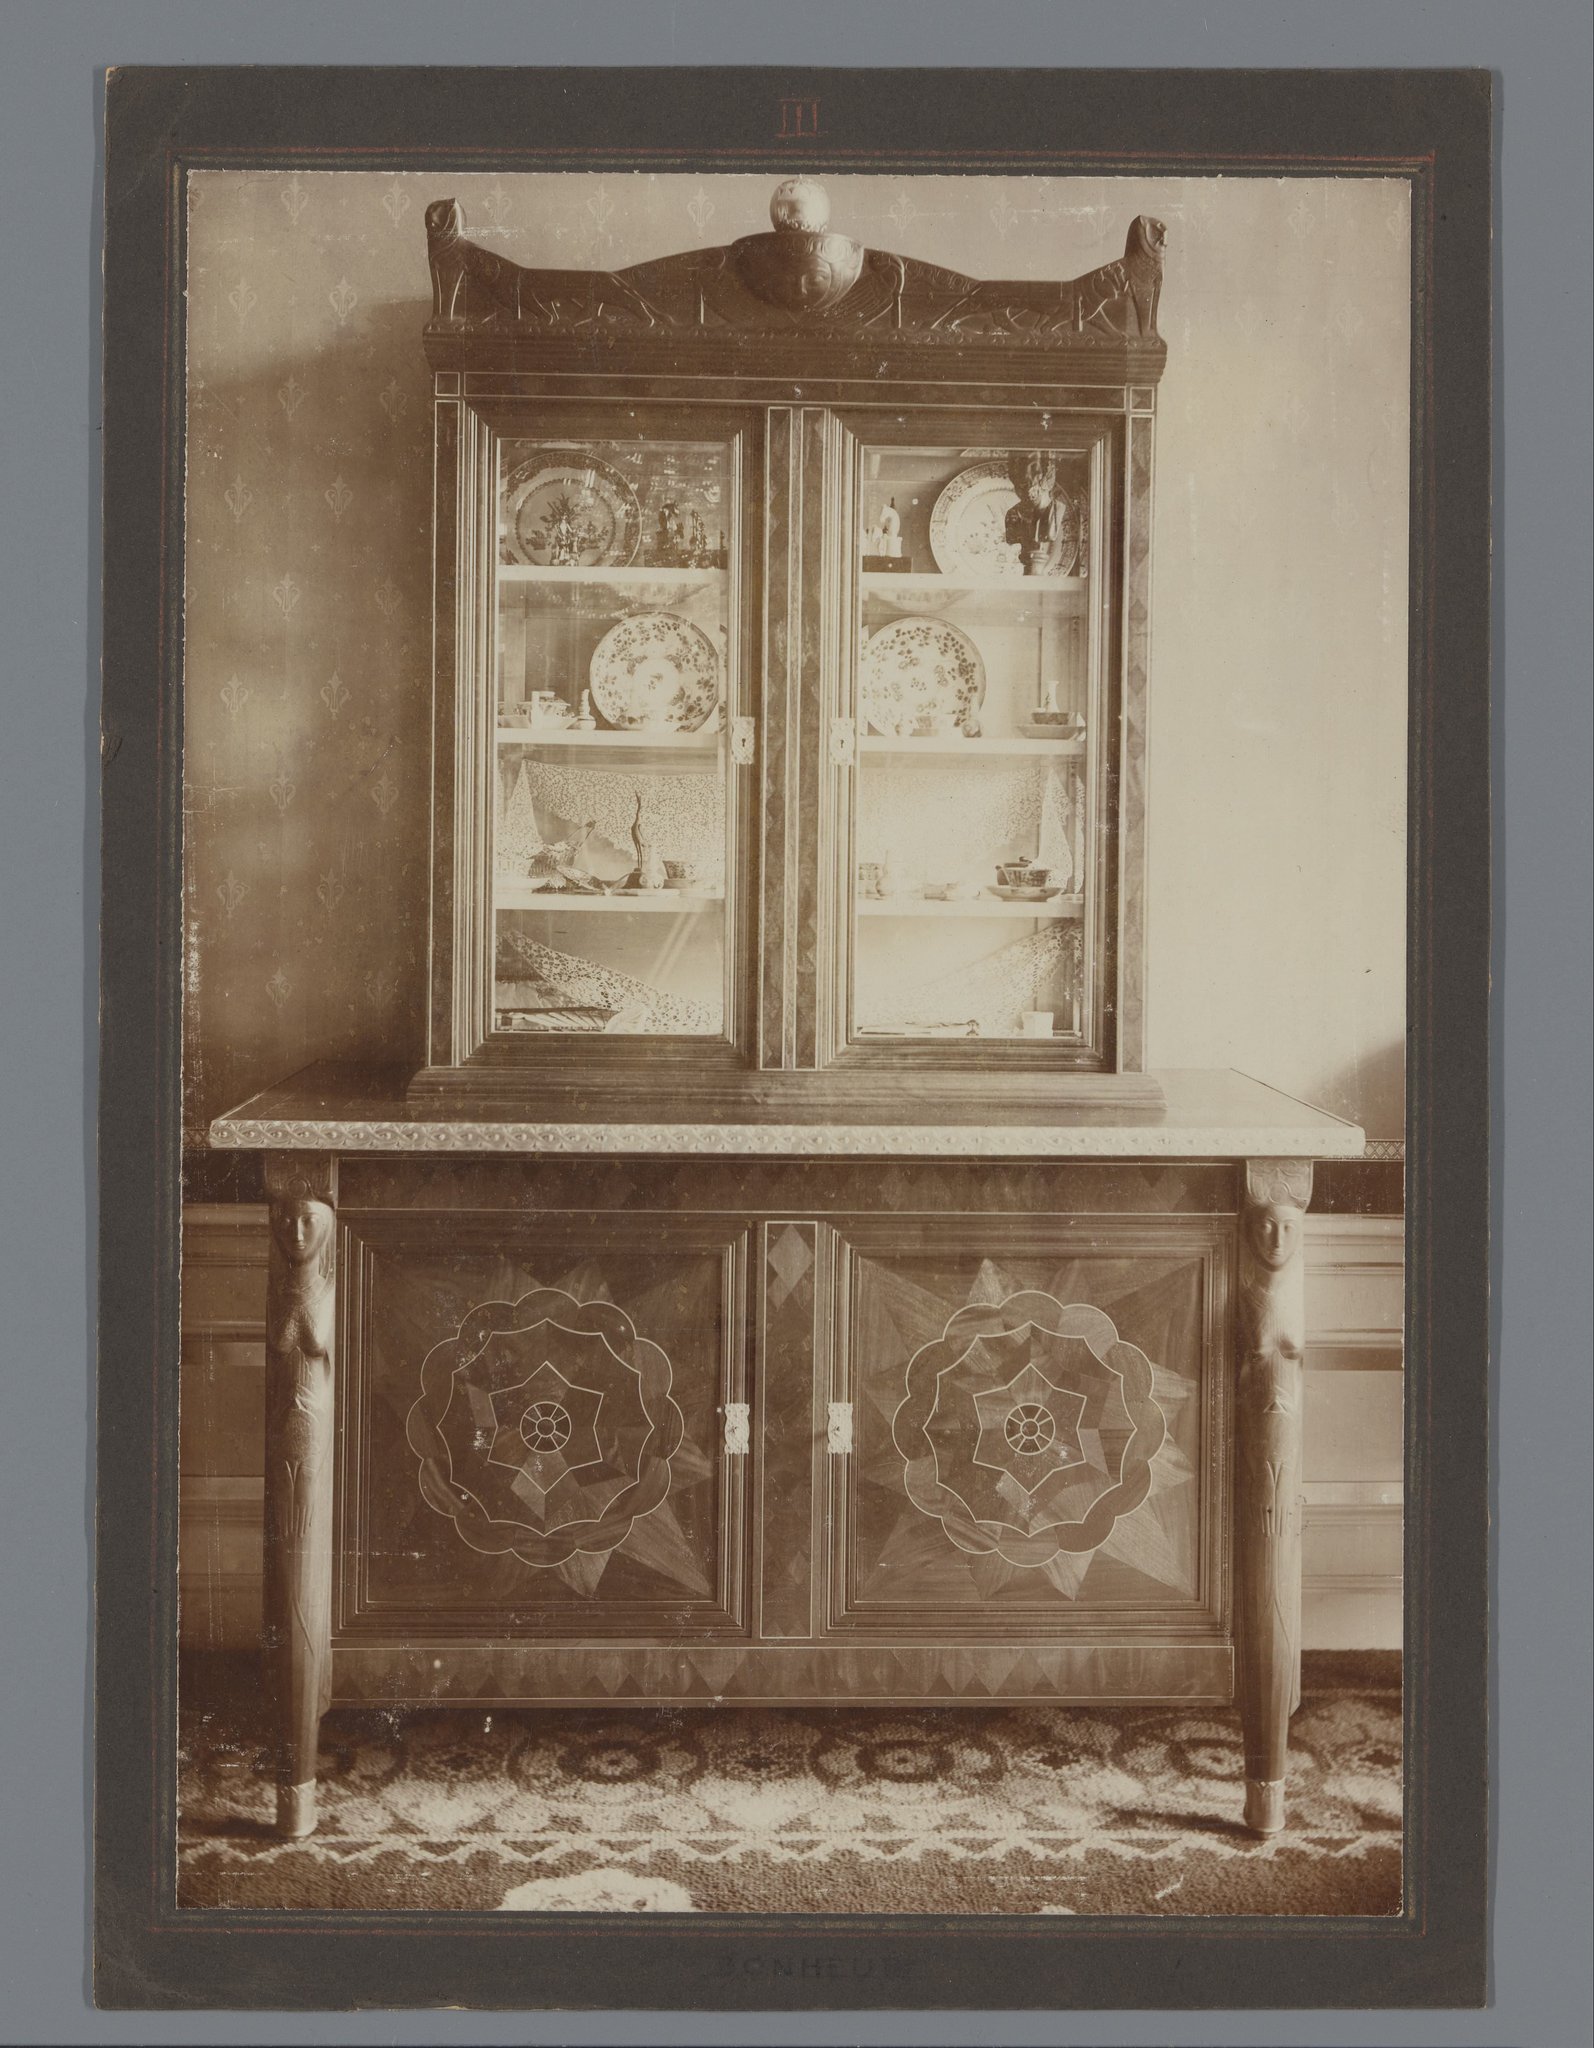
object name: photograph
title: Buffetkast naar ontwerp van Mathieu Lauweriks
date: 1910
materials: cardboard, photographic support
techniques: collodion silver print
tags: ornamental cupboard, table-ware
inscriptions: annotation: ‘BONHEUR’, annotation: ‘JM Lauweriks/ Ma[...]ts 18/ Düsseldorf/ Salonkast’, number: ‘III’, inscription: ‘salon-ameublement uitgevoerd in cuba-mahoni-/ hout met verguld en geciseleerd koperwerk,/ voor den heer J. P. W. Schuurman, Den Haag./ Ontworpen door J. L. M. Lauweriks, architect./ Uitgevoerd door de firma Wed. C. Nederkoorn,/ meubelmaker te Haarlem. + Beelhouwwerk/ van M. J. Hack te Amsterdam. + Koperwerk van/ F. Zwollo, Amsterdam +++++++++’